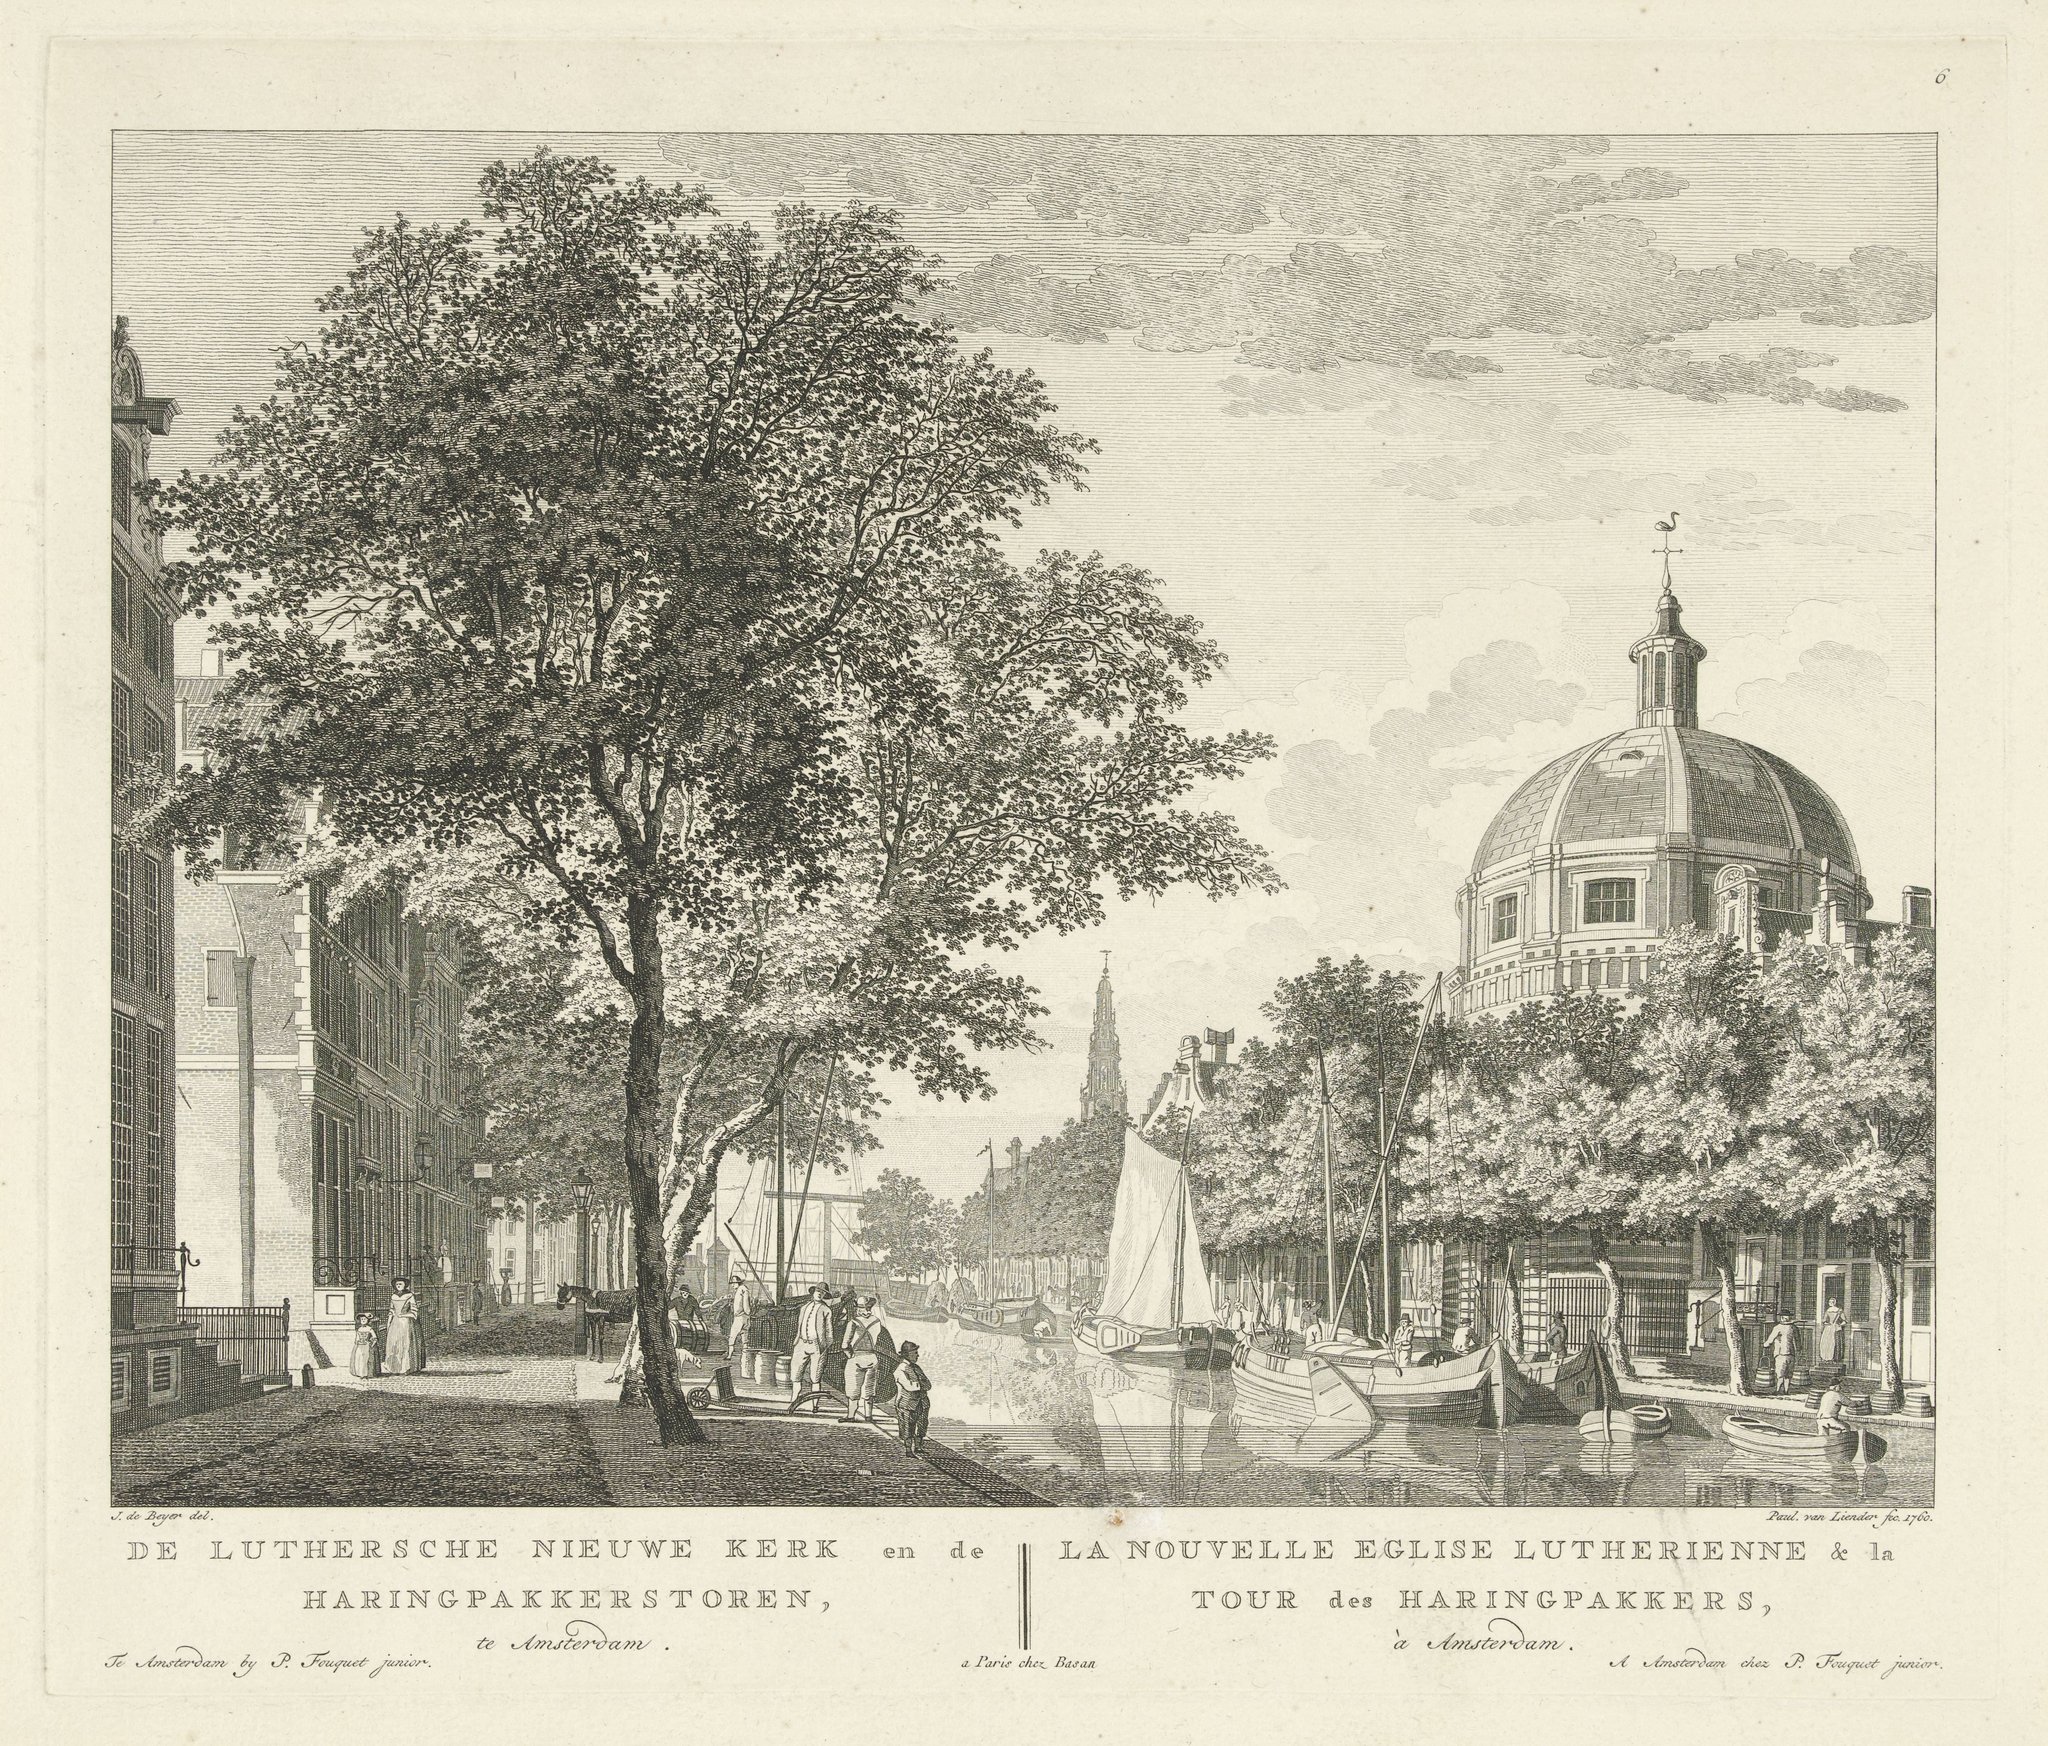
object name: print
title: Gezicht op de Ronde Lutherse Kerk te Amsterdam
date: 1760-1783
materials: paper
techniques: engraving, etching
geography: paris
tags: protestant churches and denominations (lutherans), towers ~ fortified city, church (exterior), canals, waters (in city) (+ city(-scape) with figures, staffage), street (+ city(-scape) with figures, staffage)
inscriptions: collector's mark: Lugt 2228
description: Deze prent is ook gebruikt in de zogenaamde Atlas van Fouquet.* Pierre Fouquet gaf vanaf 1760 stadsgezichten van Amsterdam - naar tekeningen van verschillende kunstenaars, gemaakt door verschillende prentmakers - uit. Deze prenten werden aanvankelijk los of in series verkocht. Zoals toen gebruikelijk kon de koper de prenten zelf laten inbinden. Hiertoe gaf Fouquet tussen 1778 en 1783 een titelblad, plattegrond en inhoudsopgave van de tot dusver 100 uitgegeven prenten uit (1). Gezien de inhoud afhankelijk was van wat de koper had verzameld verschilt de inhoud van de verschillende bewaarde Fouquetatlassen onder deze titel sterk. Ook zijn er exemplaren bekend waar tevens andere prenten aan zijn toegevoegd. Omdat er behoefte bleek aan uitleg bij de platen werd in 1783 een nieuwe versie van de atlas uitgegeven, aangevuld met tekst en twee prenten. De aangegeven volgorde veranderde maar de platen van de al eerder uitgegeven prenten bleven ongewijzigd. Deze uitgave werd in opdracht van Fouquet gedrukt bij Daniël Jean Changuion en Petrus den Hengst (2). Een tiental platen werd bijgewerkt en verscheen, met nieuw impressum, in het vervolg van Wagenaars geschiedenis van Amsterdam, uitgeven door Petrus Conradi en Folkert van der Plaats (3). Een aantal jaar na het overlijden van Fouquet kwam Evert Maaskamp met een nieuwe uitgave van de atlas, met verbeterde tekst en toevoeging van twee prenten. Op alle platen verwijderde hij het oude en liet hij zijn eigen impressum zetten (4). De huidige staat van de prent komt voor in exemplaren van de onder (1) en (2) genoemde werken. * Onder de Atlas van Fouquet of Fouquetatlas verstaan we de hieronder vermelde publicaties (1), (2) en (4). (1). Afbeeldingen van de wyd-vermaarde koopstad Amsterdam benevens des zelvs voornaamste gebouwen en gezigten alle naar het leeven getekend / Receuil des edifices les plus considerables et des plus belles vues, de la fameuse ville d'Amsterdam, dessinées d'après nature. Amsterdam: Pierre Fouquet, 1778-1783. (2). Nieuwe atlas, van de voornaamste gebouwen en gezigten der stad Amsterdam, met derzelver beknopte beschryvingen. 2 delen. Amsterdam: Daniël Jean Changuion en Petrus den Hengst [in opdracht van Pierre Fouquet], 1783. (3). Stijl, Simon. Amsterdam, in zyne geschiedenissen, voorregten, koophandel, gebouwen, kerkenstaat, schoolen, schutterye, gilden en regeeringe, beschreeven. Om te dienen ten vervolge op het werk van Jan Wagenaar (…). 10 delen. Amsterdam en Harlingen: Petrus Conradi en Folkert van der Plaats, 1788-1801. (4). Nieuwe atlas, van de voornaamste gebouwen en gezigten der stad Amsterdam. Met derzelver beknopte beschryvingen. Amsterdam: Evert Maaskamp, 1805. * Het aantal vermelde staten is gebaseerd op het aantal gevonden staten. Mogelijk zijn er meer staten van deze prent. Voor eerste bekende staat zie RP-P-AO-24-5-1. Voor derde bekende staat zie RP-P-AO-24-5-2.